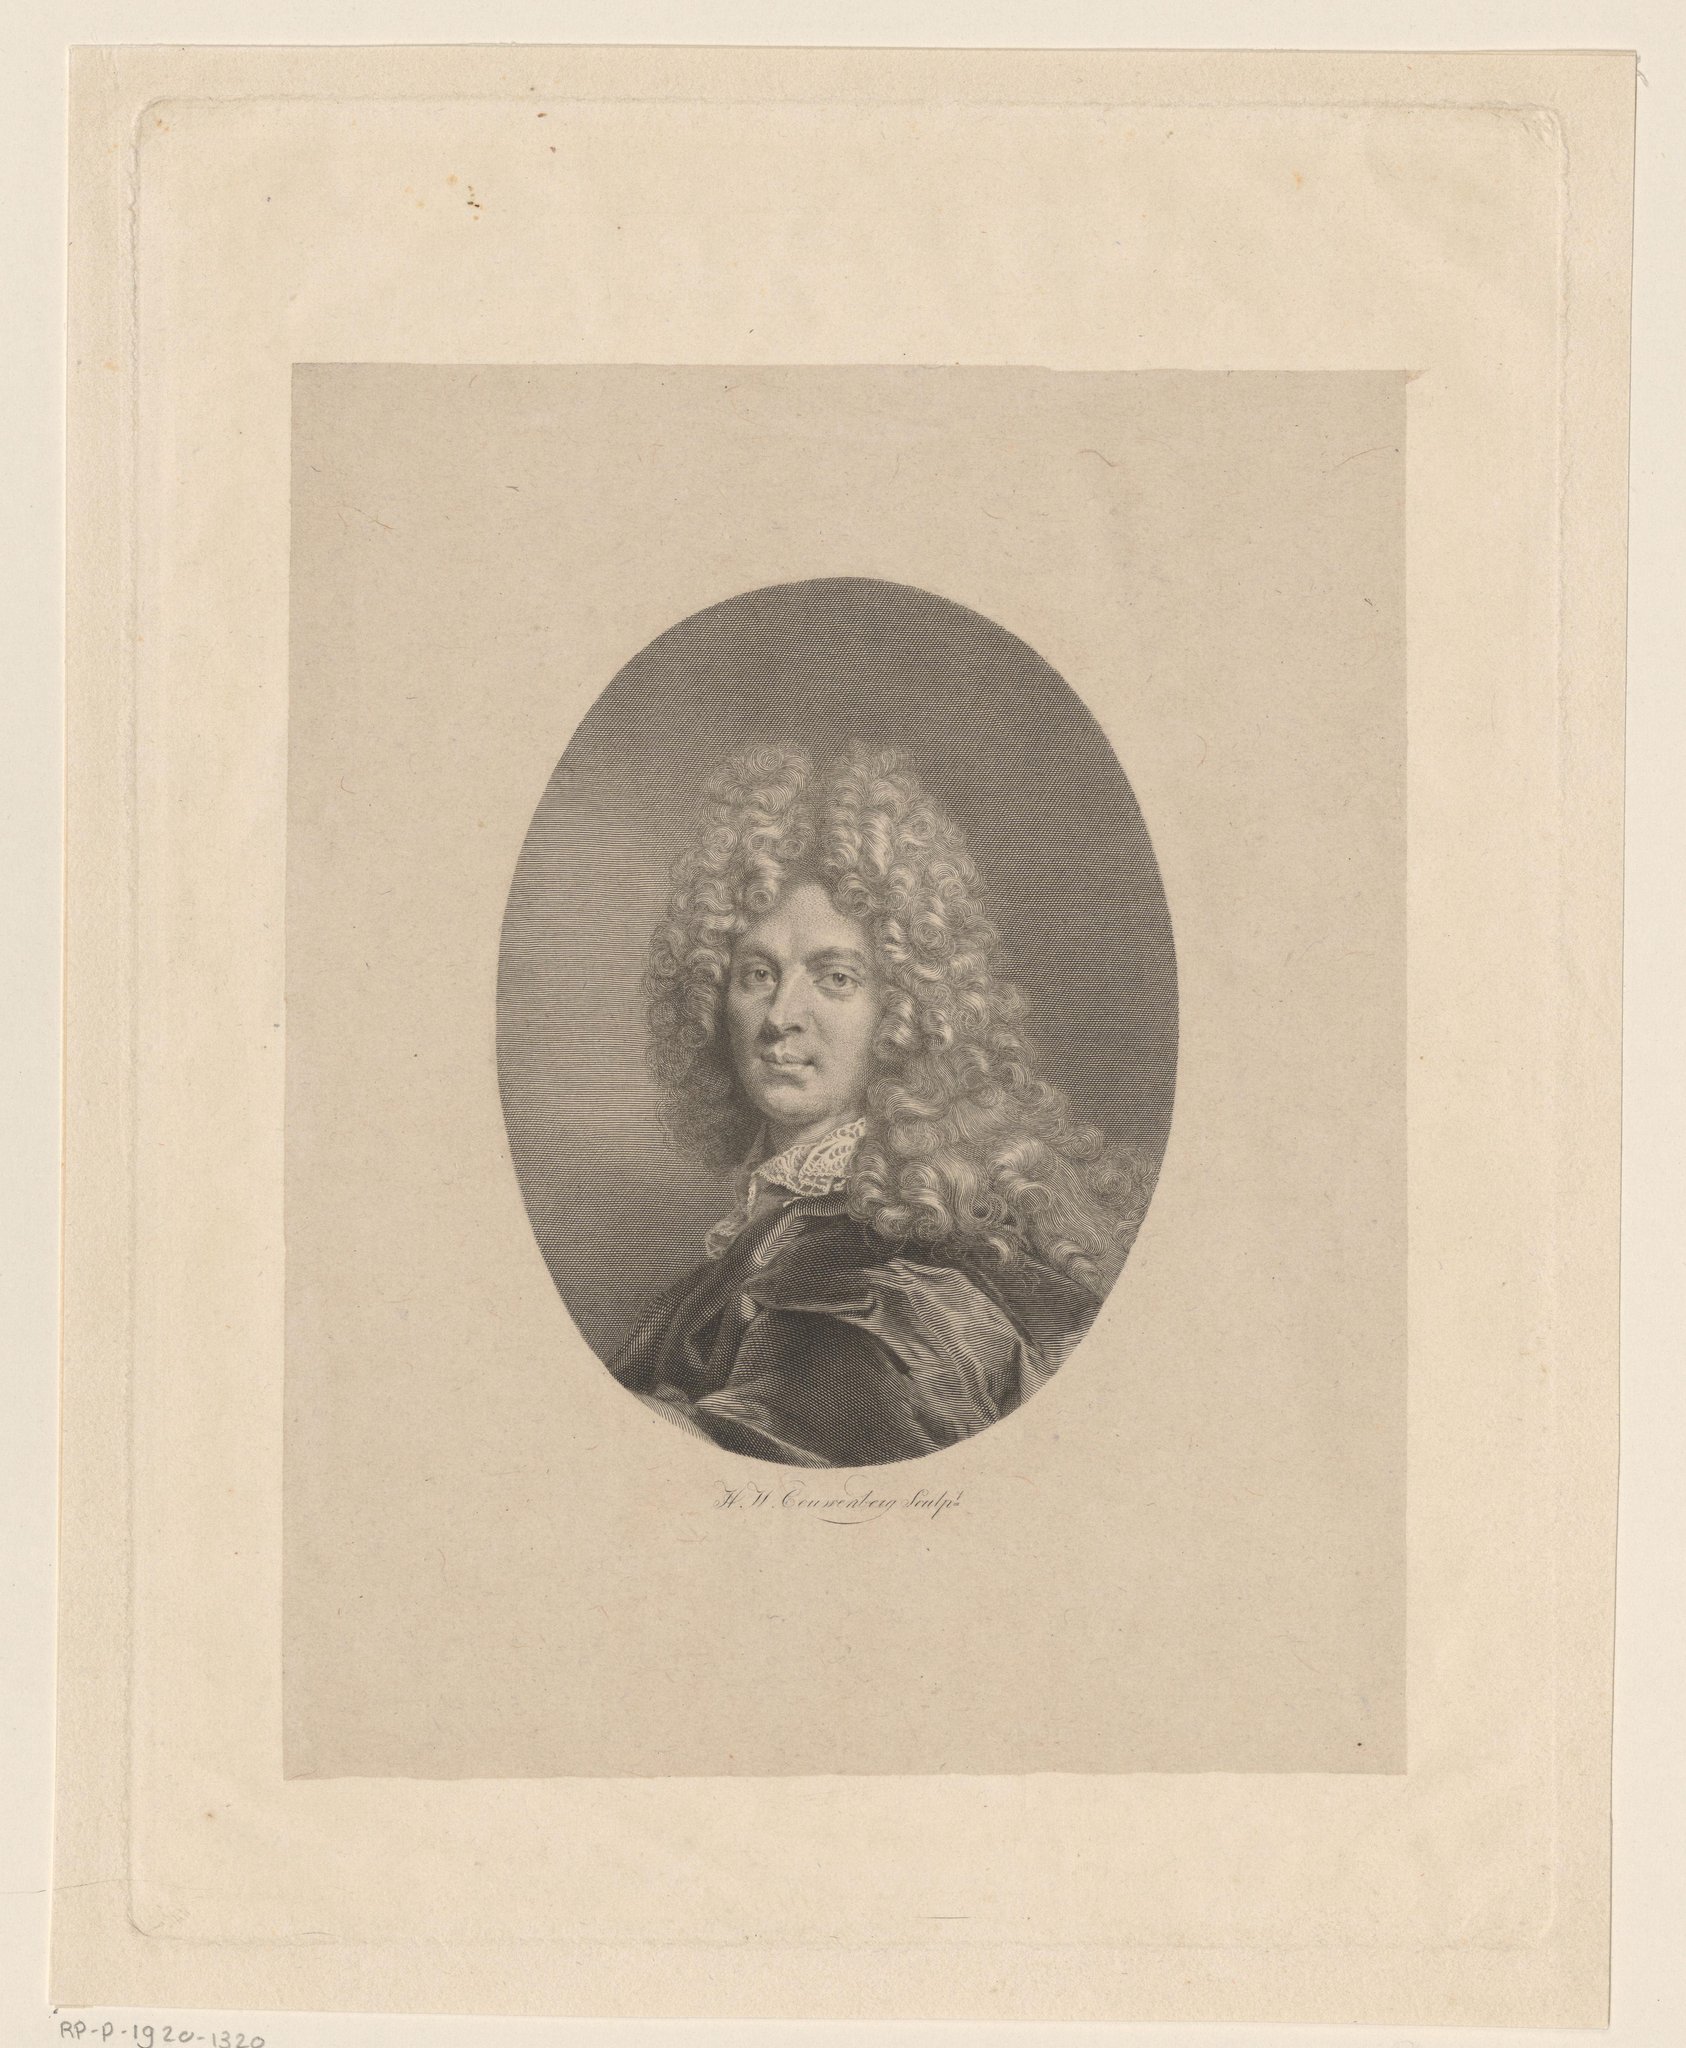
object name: print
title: Portret van Pierre-Vincent Bertin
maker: henricus wilhelmus couwenberg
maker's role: draughtsman, print maker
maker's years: 1814-1845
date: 1824-1845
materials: paper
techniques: engraving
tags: historical persons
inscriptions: collector's mark: Lugt 2228